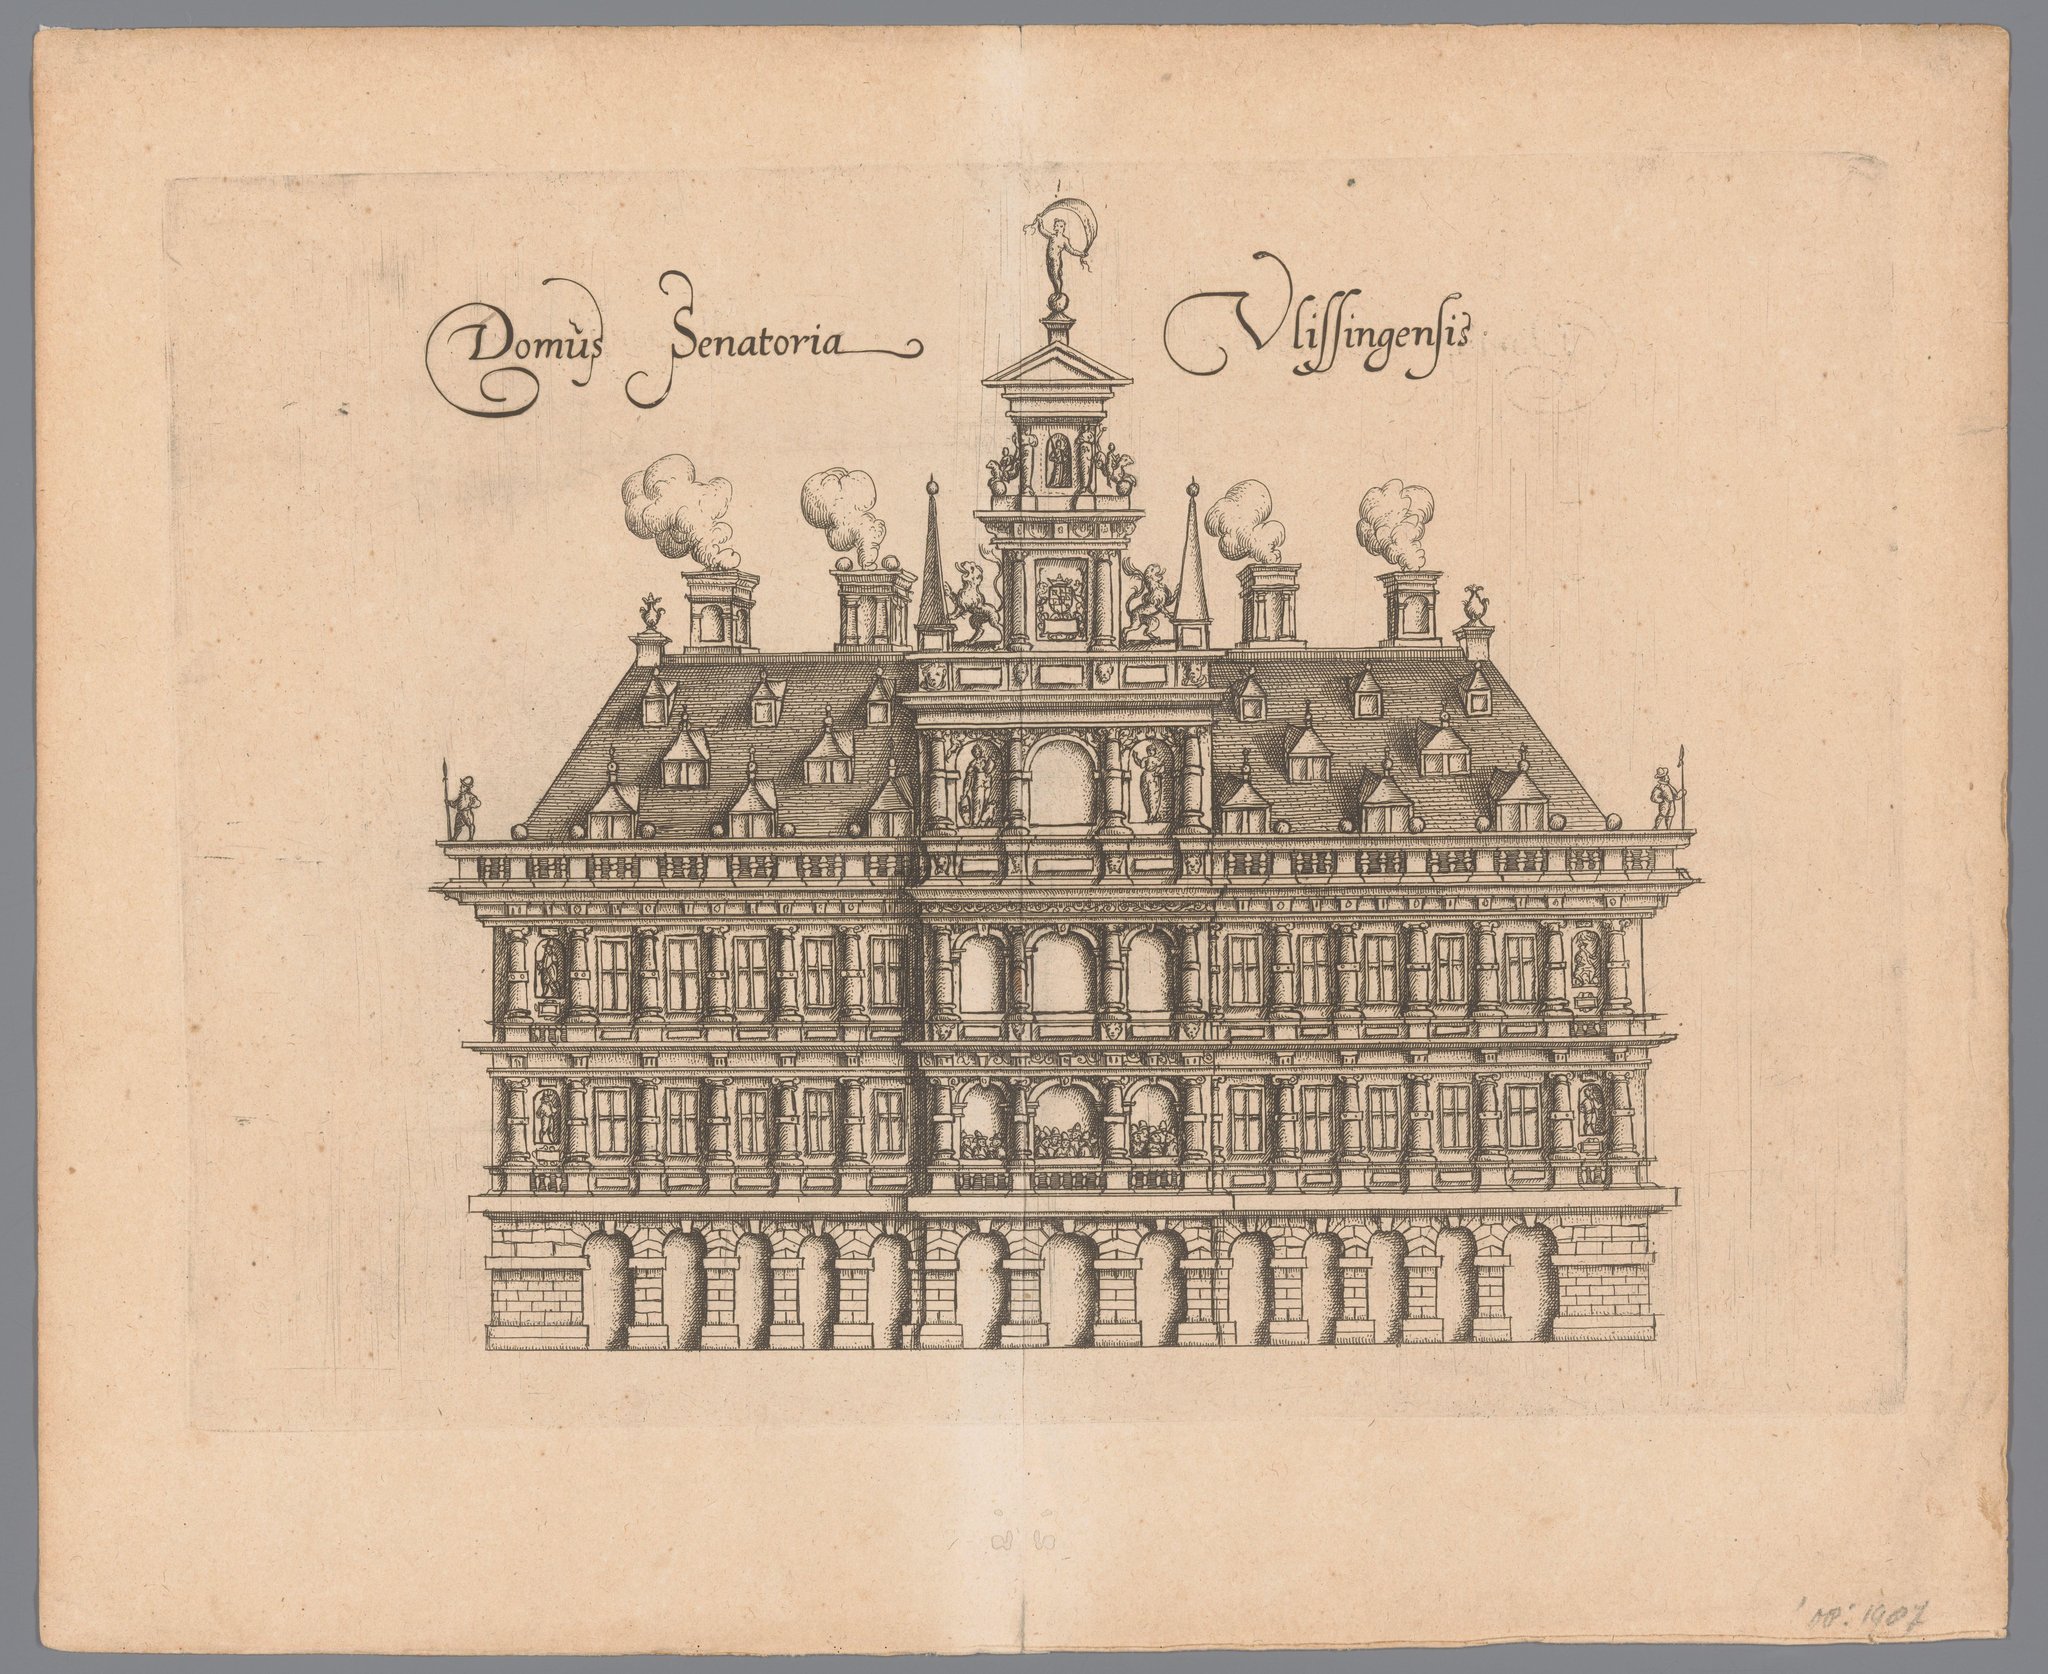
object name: book illustration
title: Domus Senatoria Vlissingensis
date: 1612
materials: paper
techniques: etching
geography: amsterdam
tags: townhall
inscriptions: collector's mark: Lugt 2228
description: Prent uit: Guicciardini, Lodovico. Beschryvinghe van alle de Neder-landen, anderssins ghenoemt Neder-Duytslandt (…). Amsterdam: Willem Janszoon Blaeu, 1612, tussen p. 270 en 271.